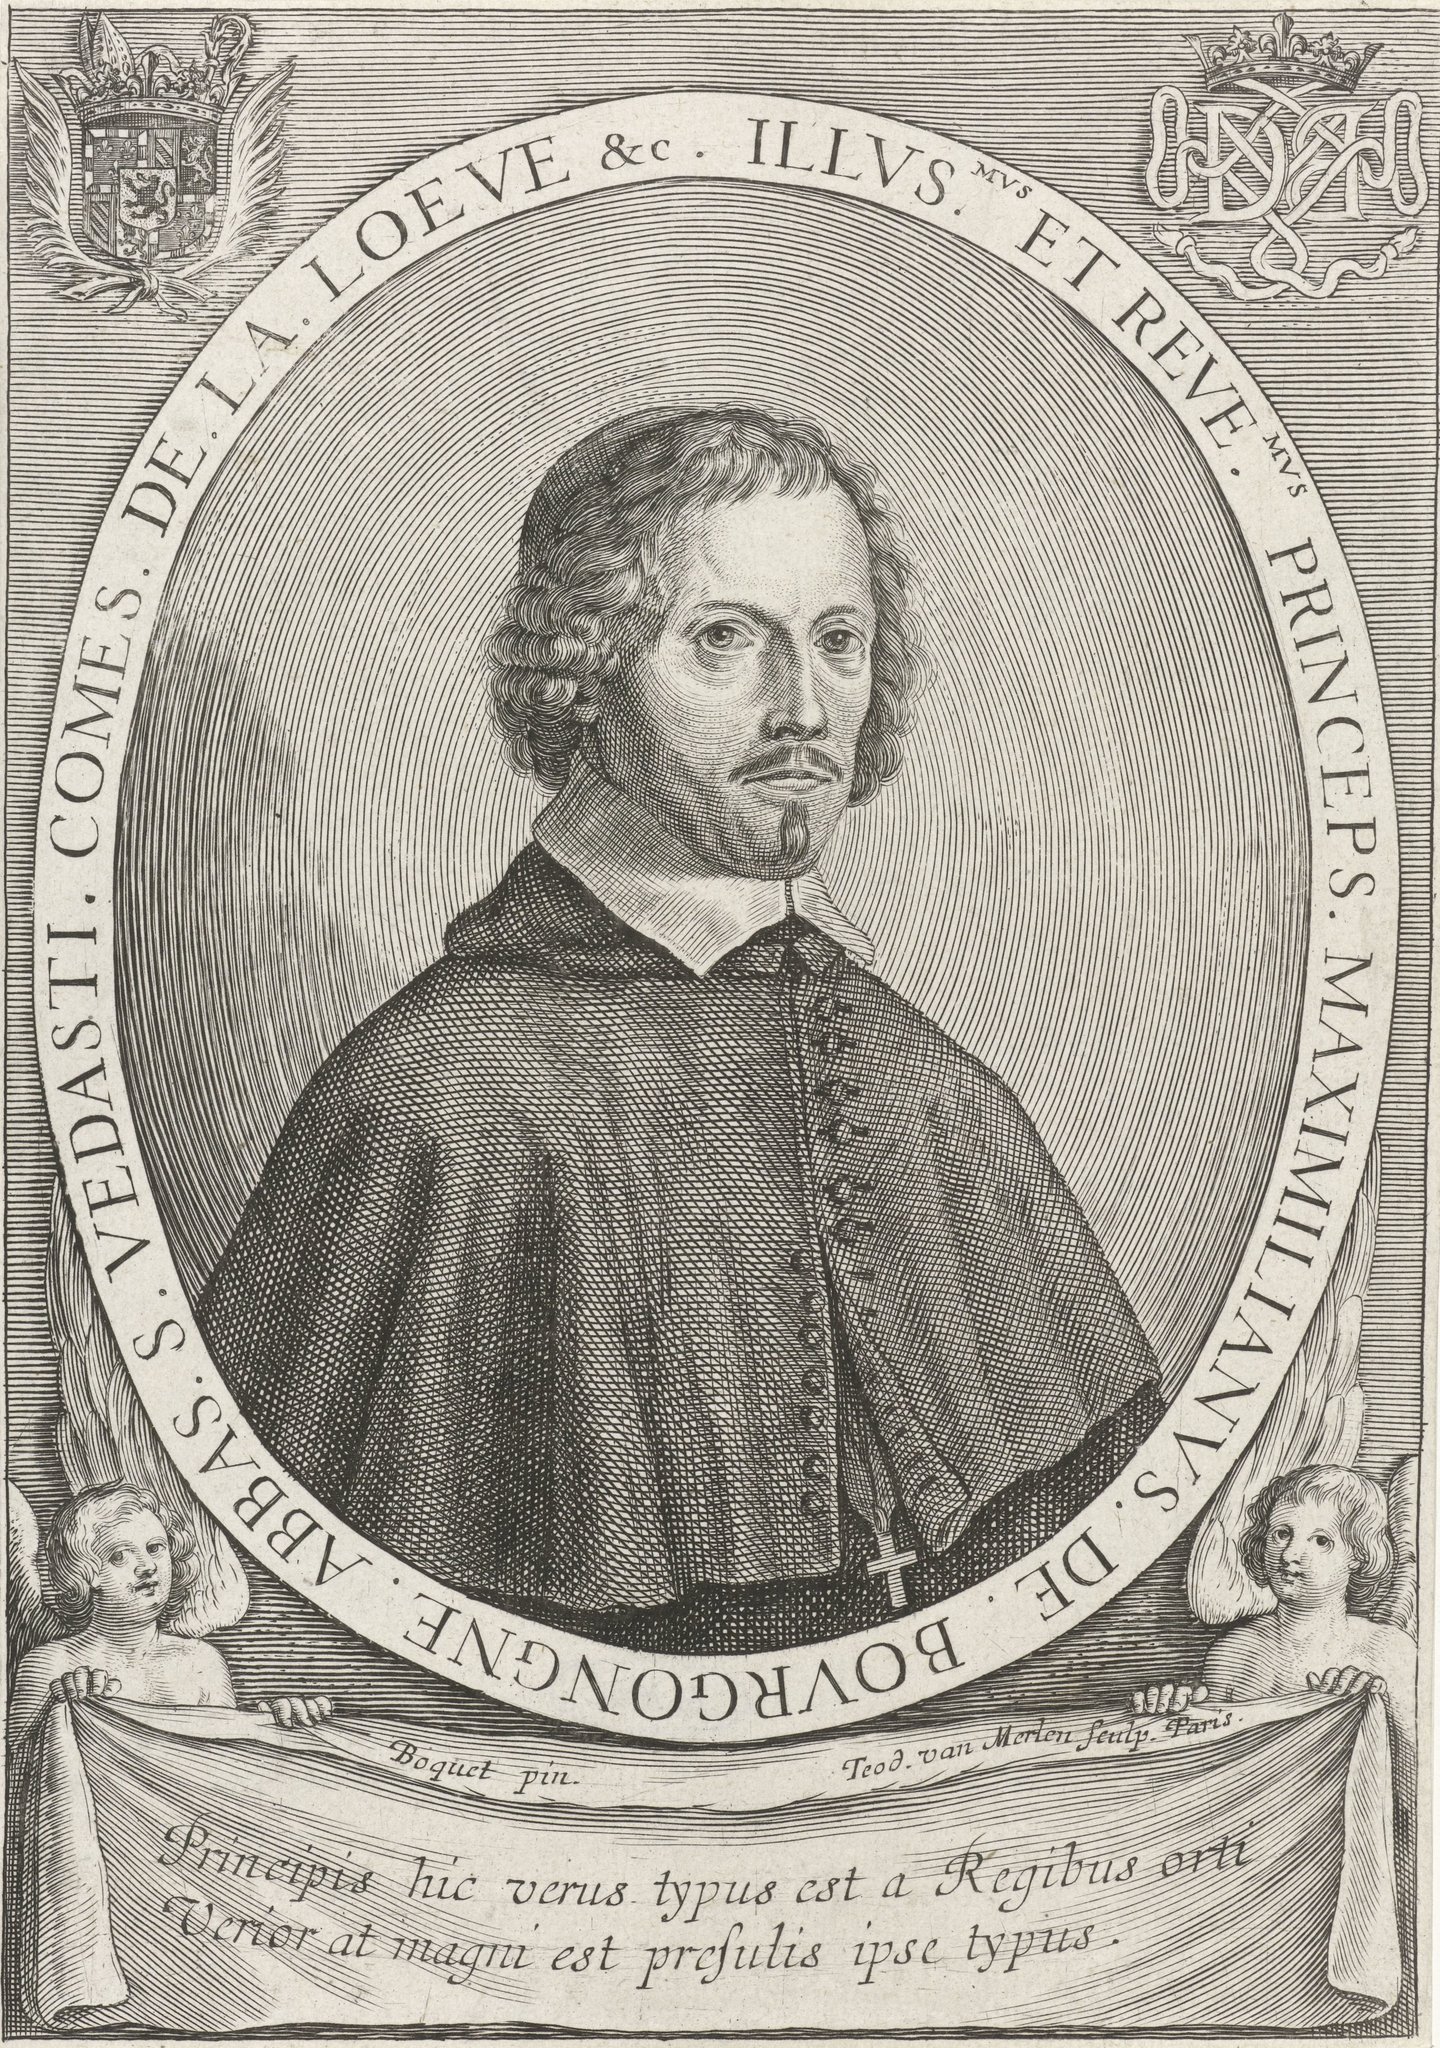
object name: print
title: Portret van Maximilien de Bourgogne, graaf van La Loève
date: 1619-1672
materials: paper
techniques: engraving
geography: paris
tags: maximilien de bourgogne (graaf van la loève)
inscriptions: collector's mark: Lugt 2228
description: Portret van Maximilien de Bourgogne, graaf van La Loève, in religieuze kledij. In de bovenhoeken zijn wapenschilden. Onderaan houden twee engelen een doek vast met een tweeregelige tekst in het Latijn.